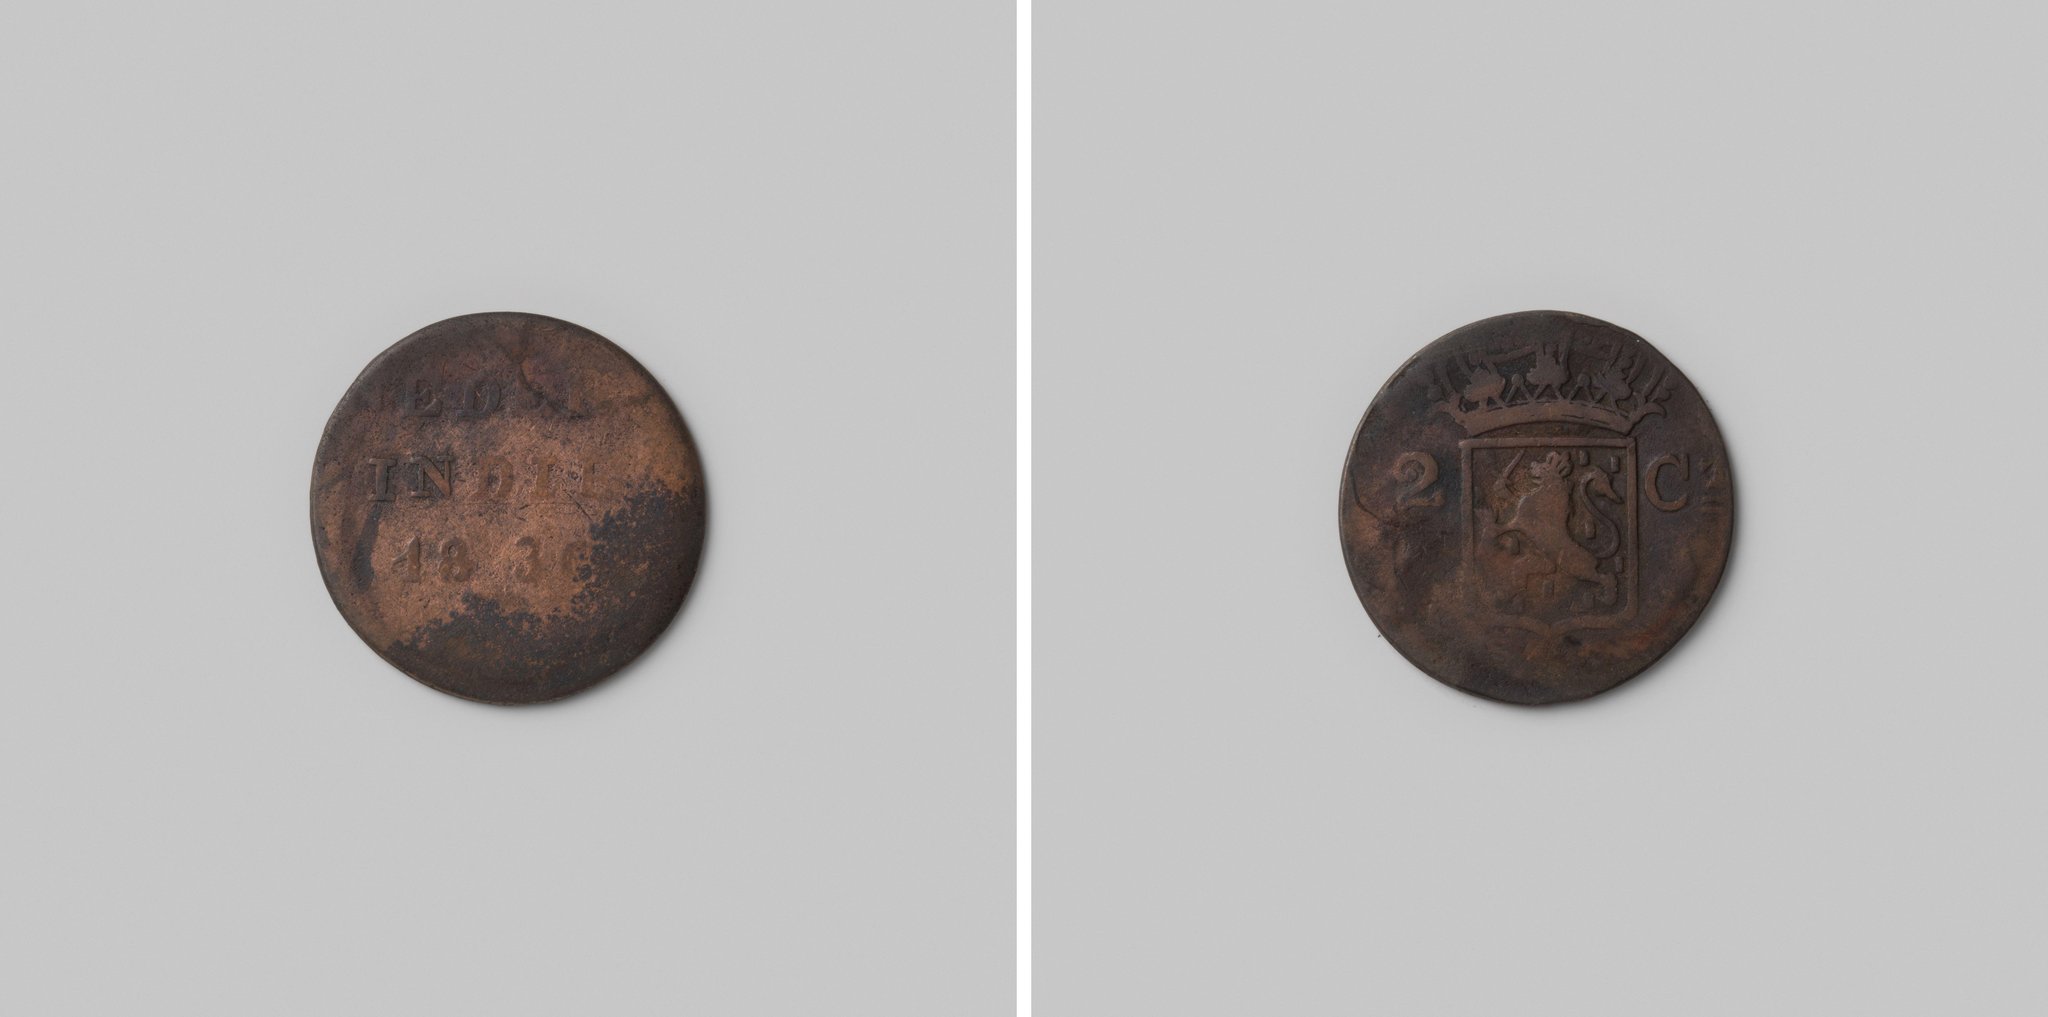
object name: coin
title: Munt van twee cent uit Nederlands-Indië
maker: Anonymous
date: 1836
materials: copper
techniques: striking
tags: dutch east indies, the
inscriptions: inscription: ‘Jacques Schulman / Numismaat / Keizersgracht 448 / Amsterdam-C.’, inscription: ‘NEDERL / INDIE / 1836’, inscription: ‘2 Ct’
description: Koperen muntje van 2 cent uit Nederlands-Indië. Voorzijde: opschrift. Keerzijde: gekroond wapen met leeuw erin. Links van het wapen een 2 en rechts van het wapen een Ct. Het muntje zit in een envelopje met opschrift.